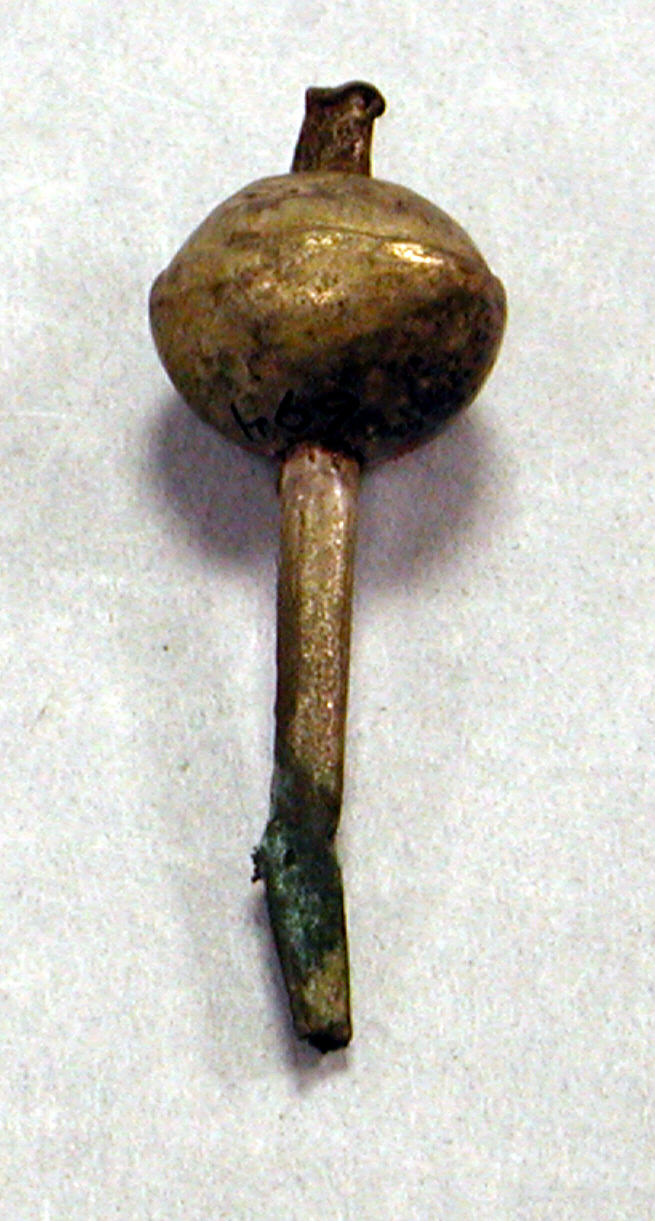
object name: scepter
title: Hammered Silver Miniature Scepter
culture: peruvian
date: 701-1566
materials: gilt, silver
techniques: hammering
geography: peru